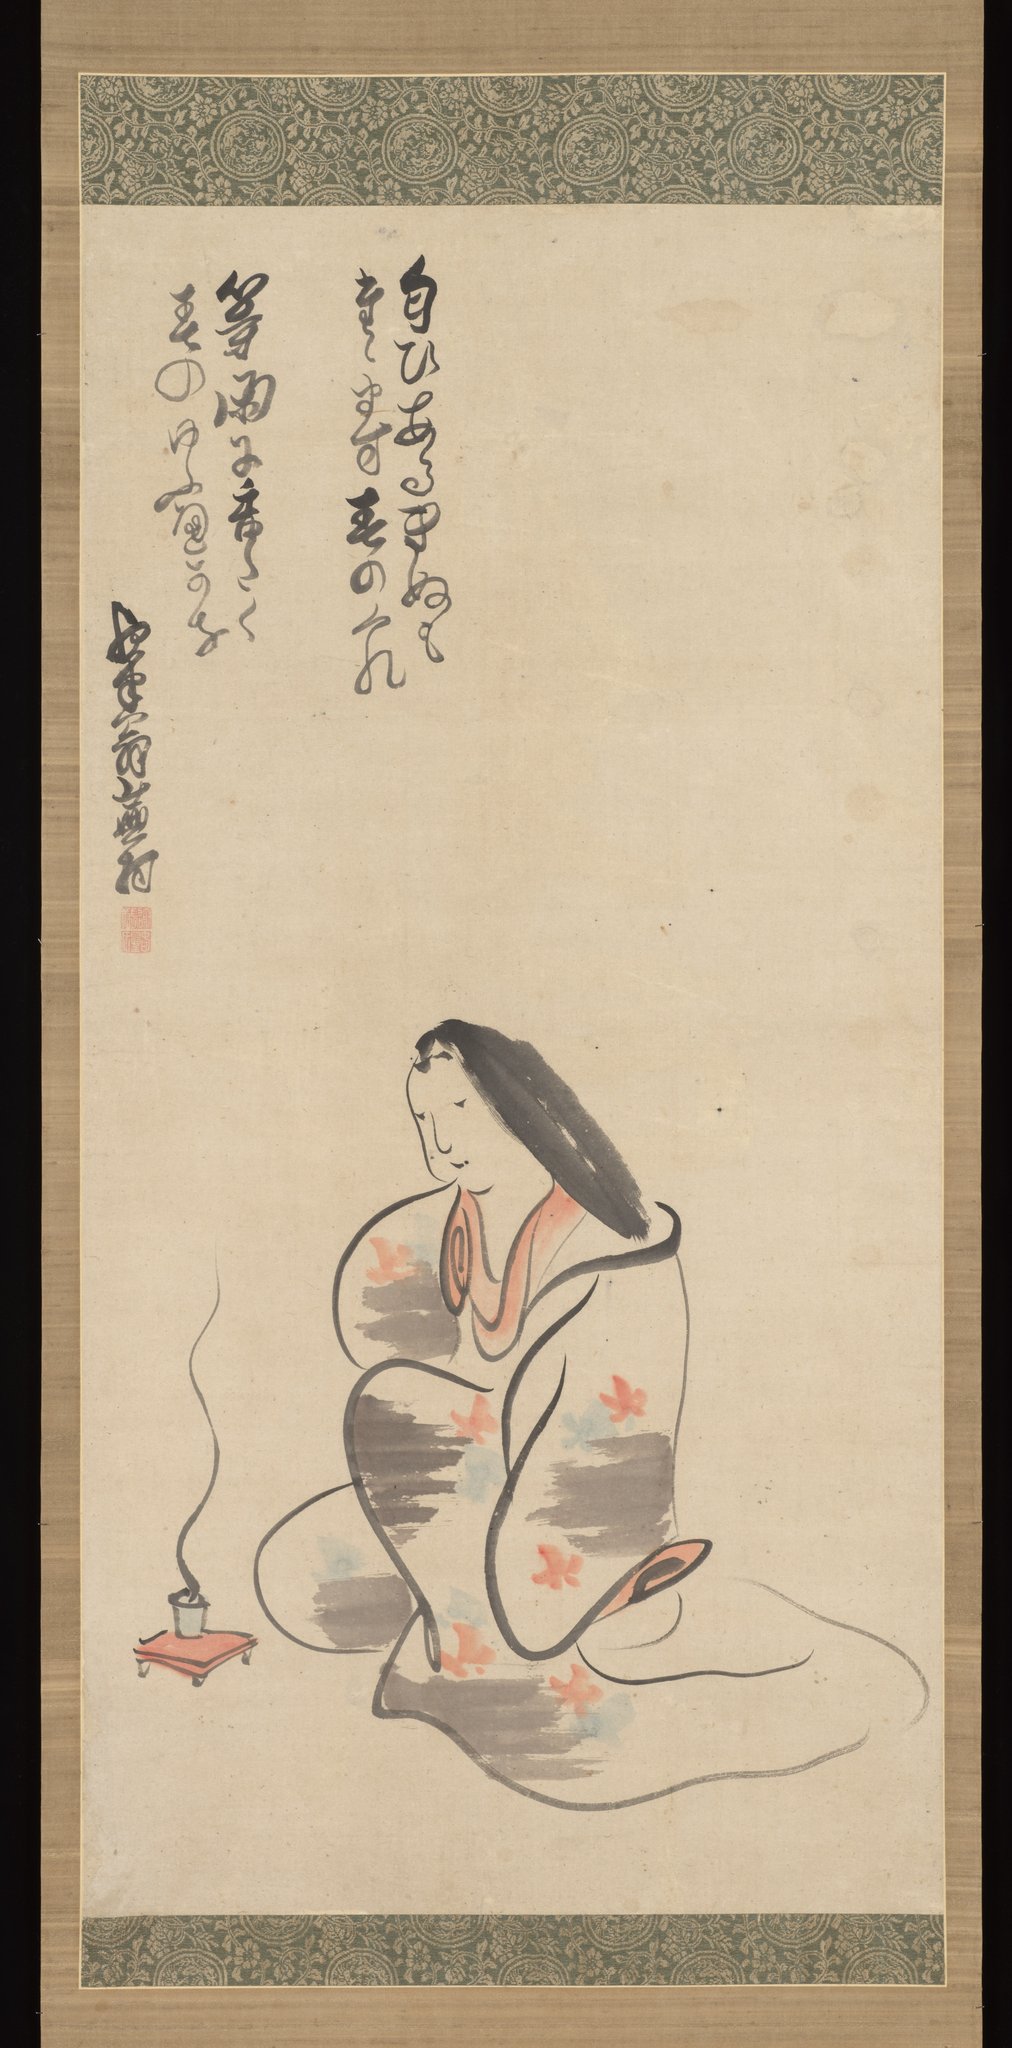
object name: hanging scroll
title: Woman Burning Incense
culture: japanese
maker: yosa buson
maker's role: artist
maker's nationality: japanese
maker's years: 1716-1783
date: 1701-1800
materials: ink, paper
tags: women,incense burners